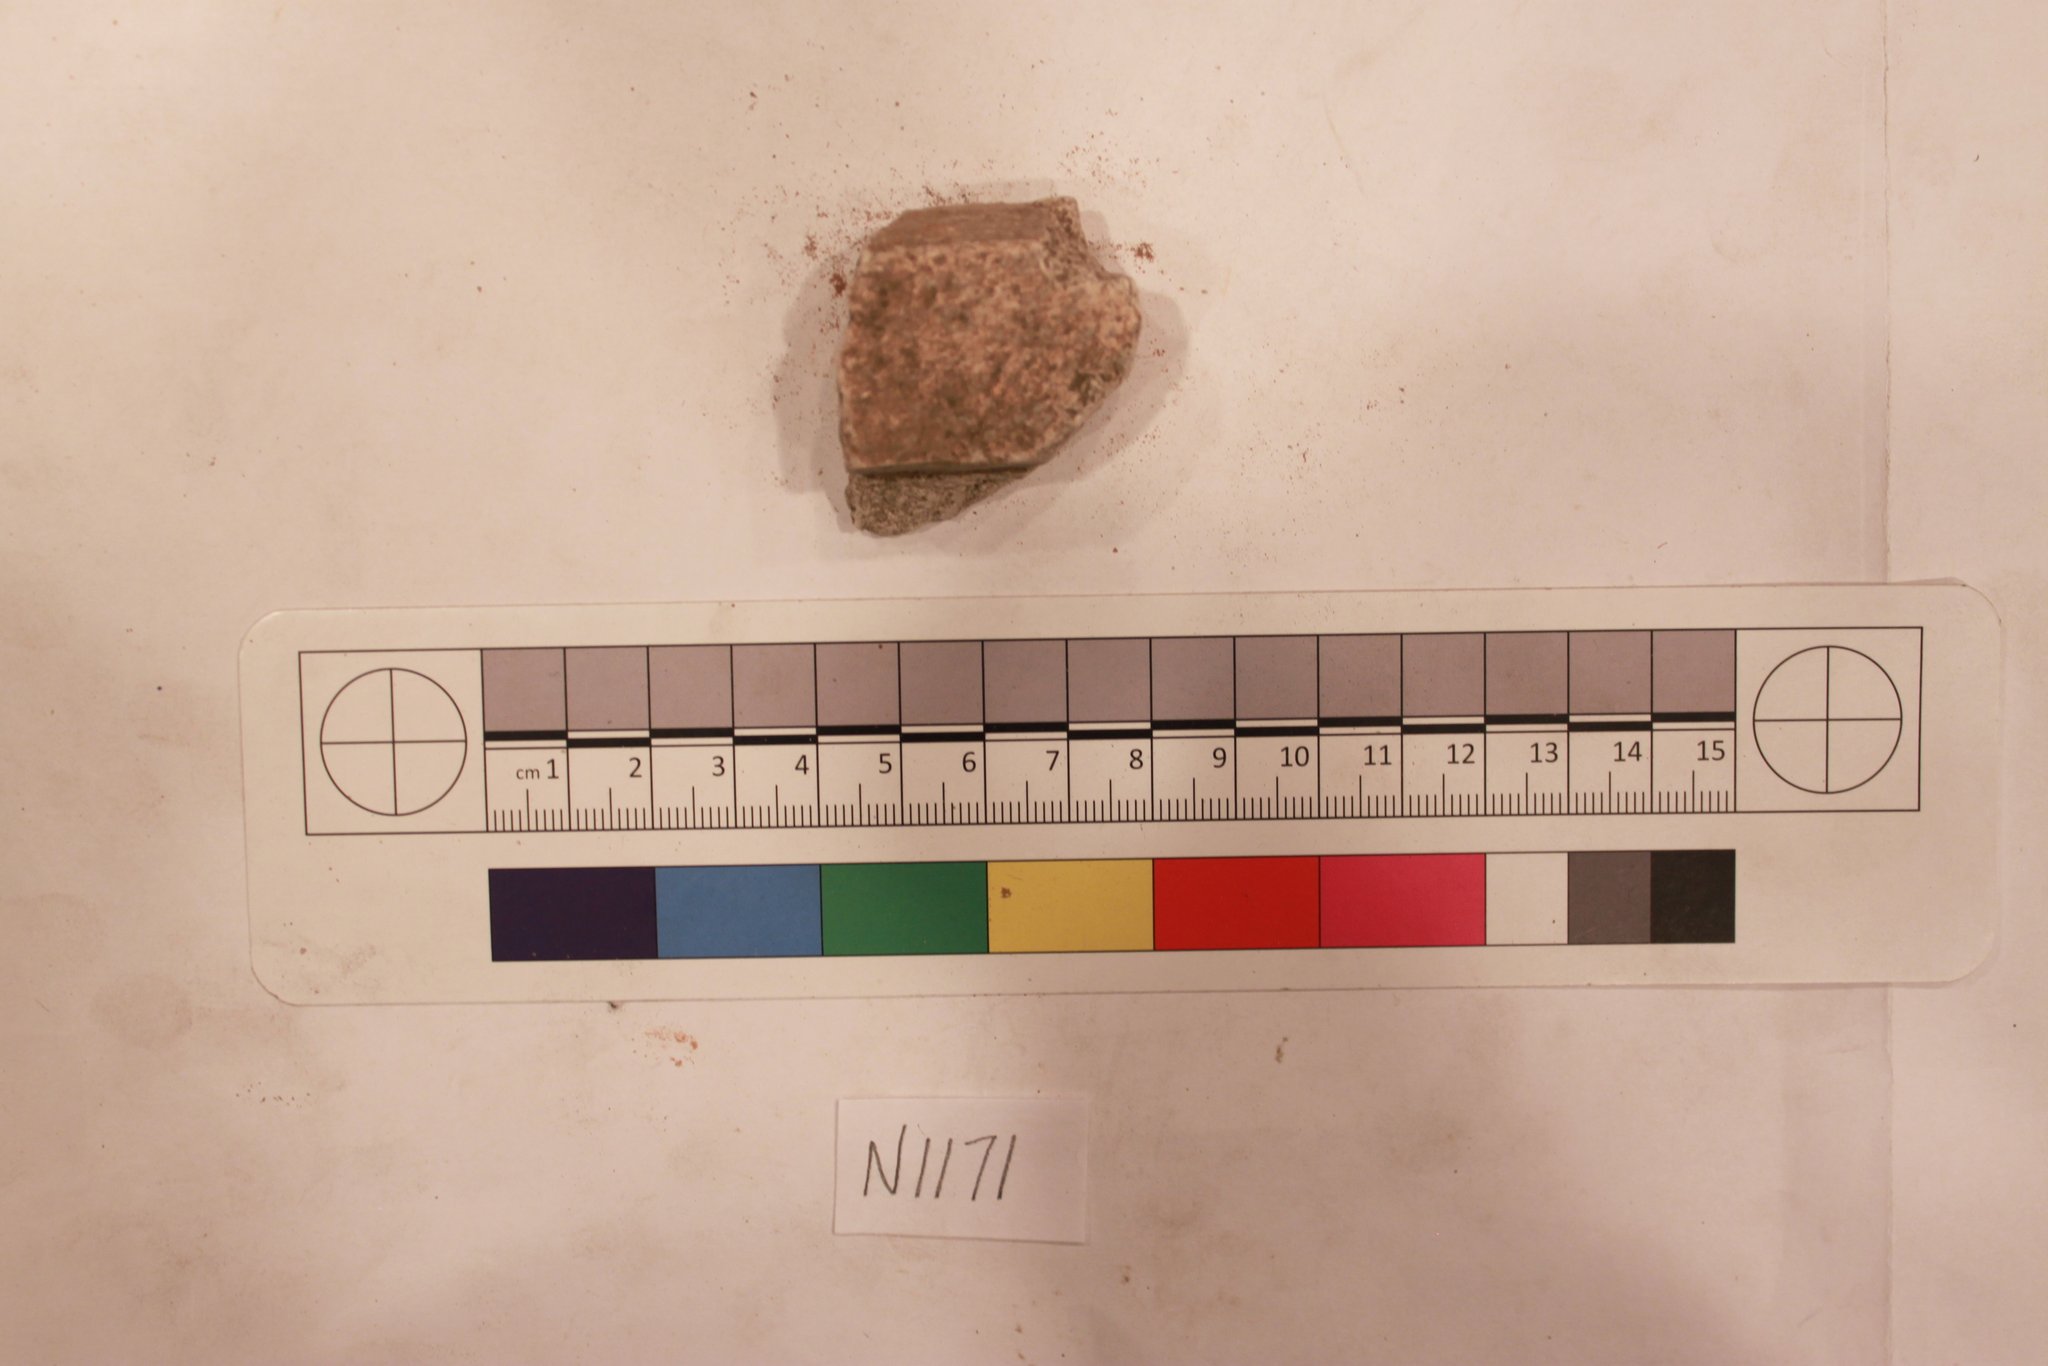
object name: fragment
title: Stucco Fragment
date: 701-1200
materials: plaster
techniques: carving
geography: iran